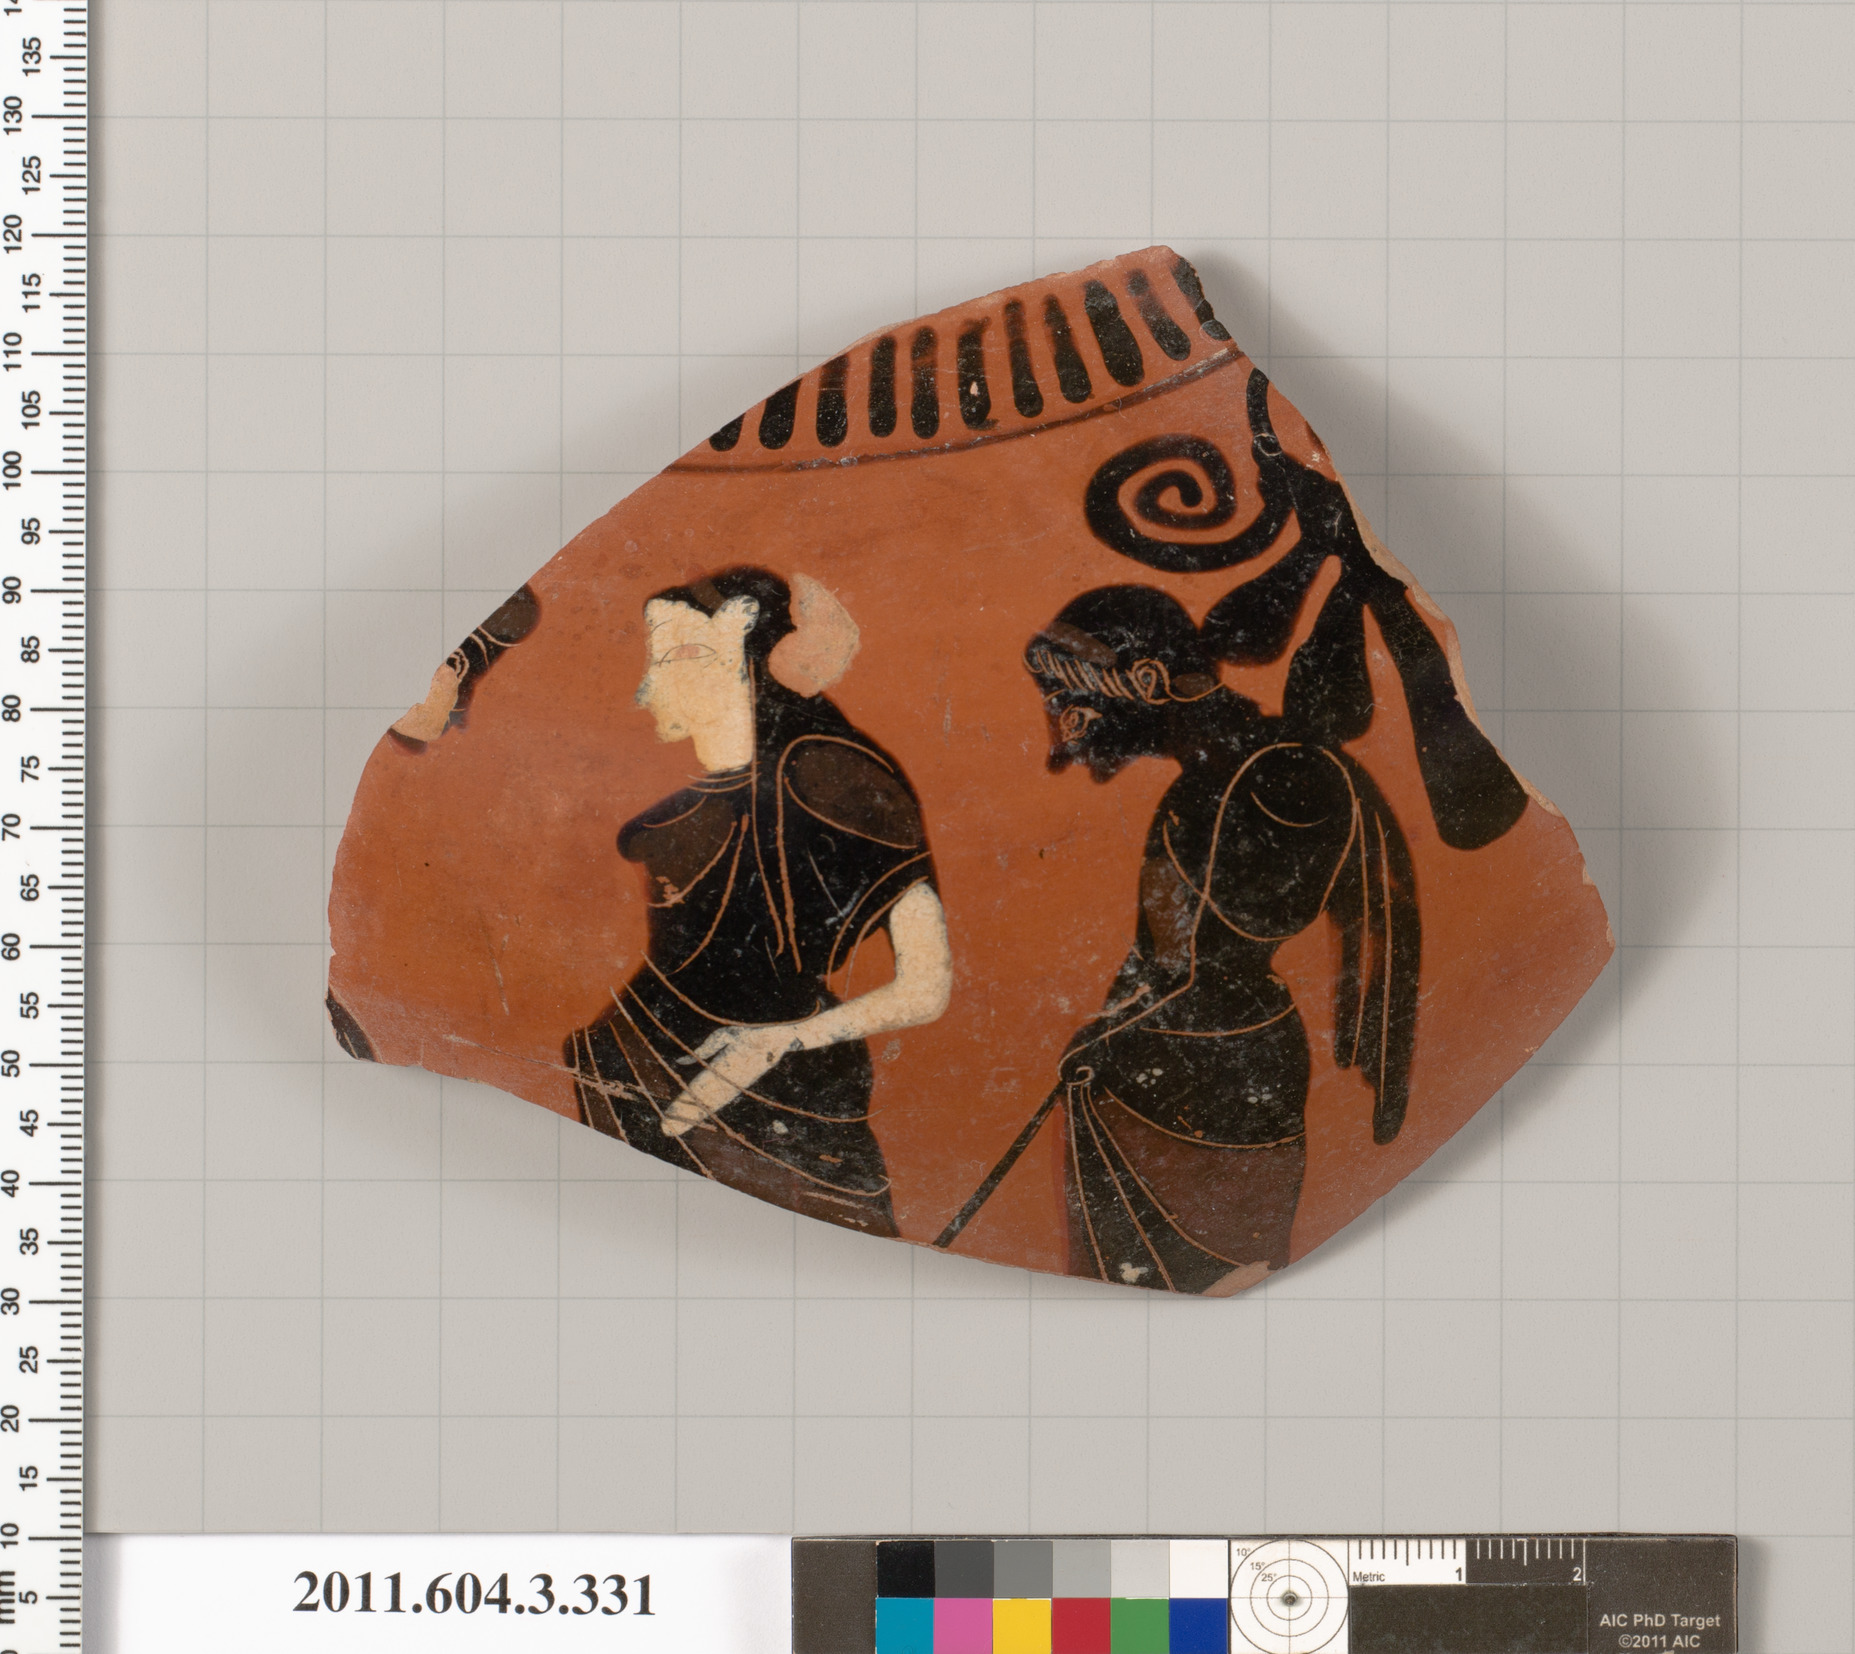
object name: neck amphora fragment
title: Terracotta fragment of a neck-amphora (jar)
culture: greek, attic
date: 530-520 BCE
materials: terracotta